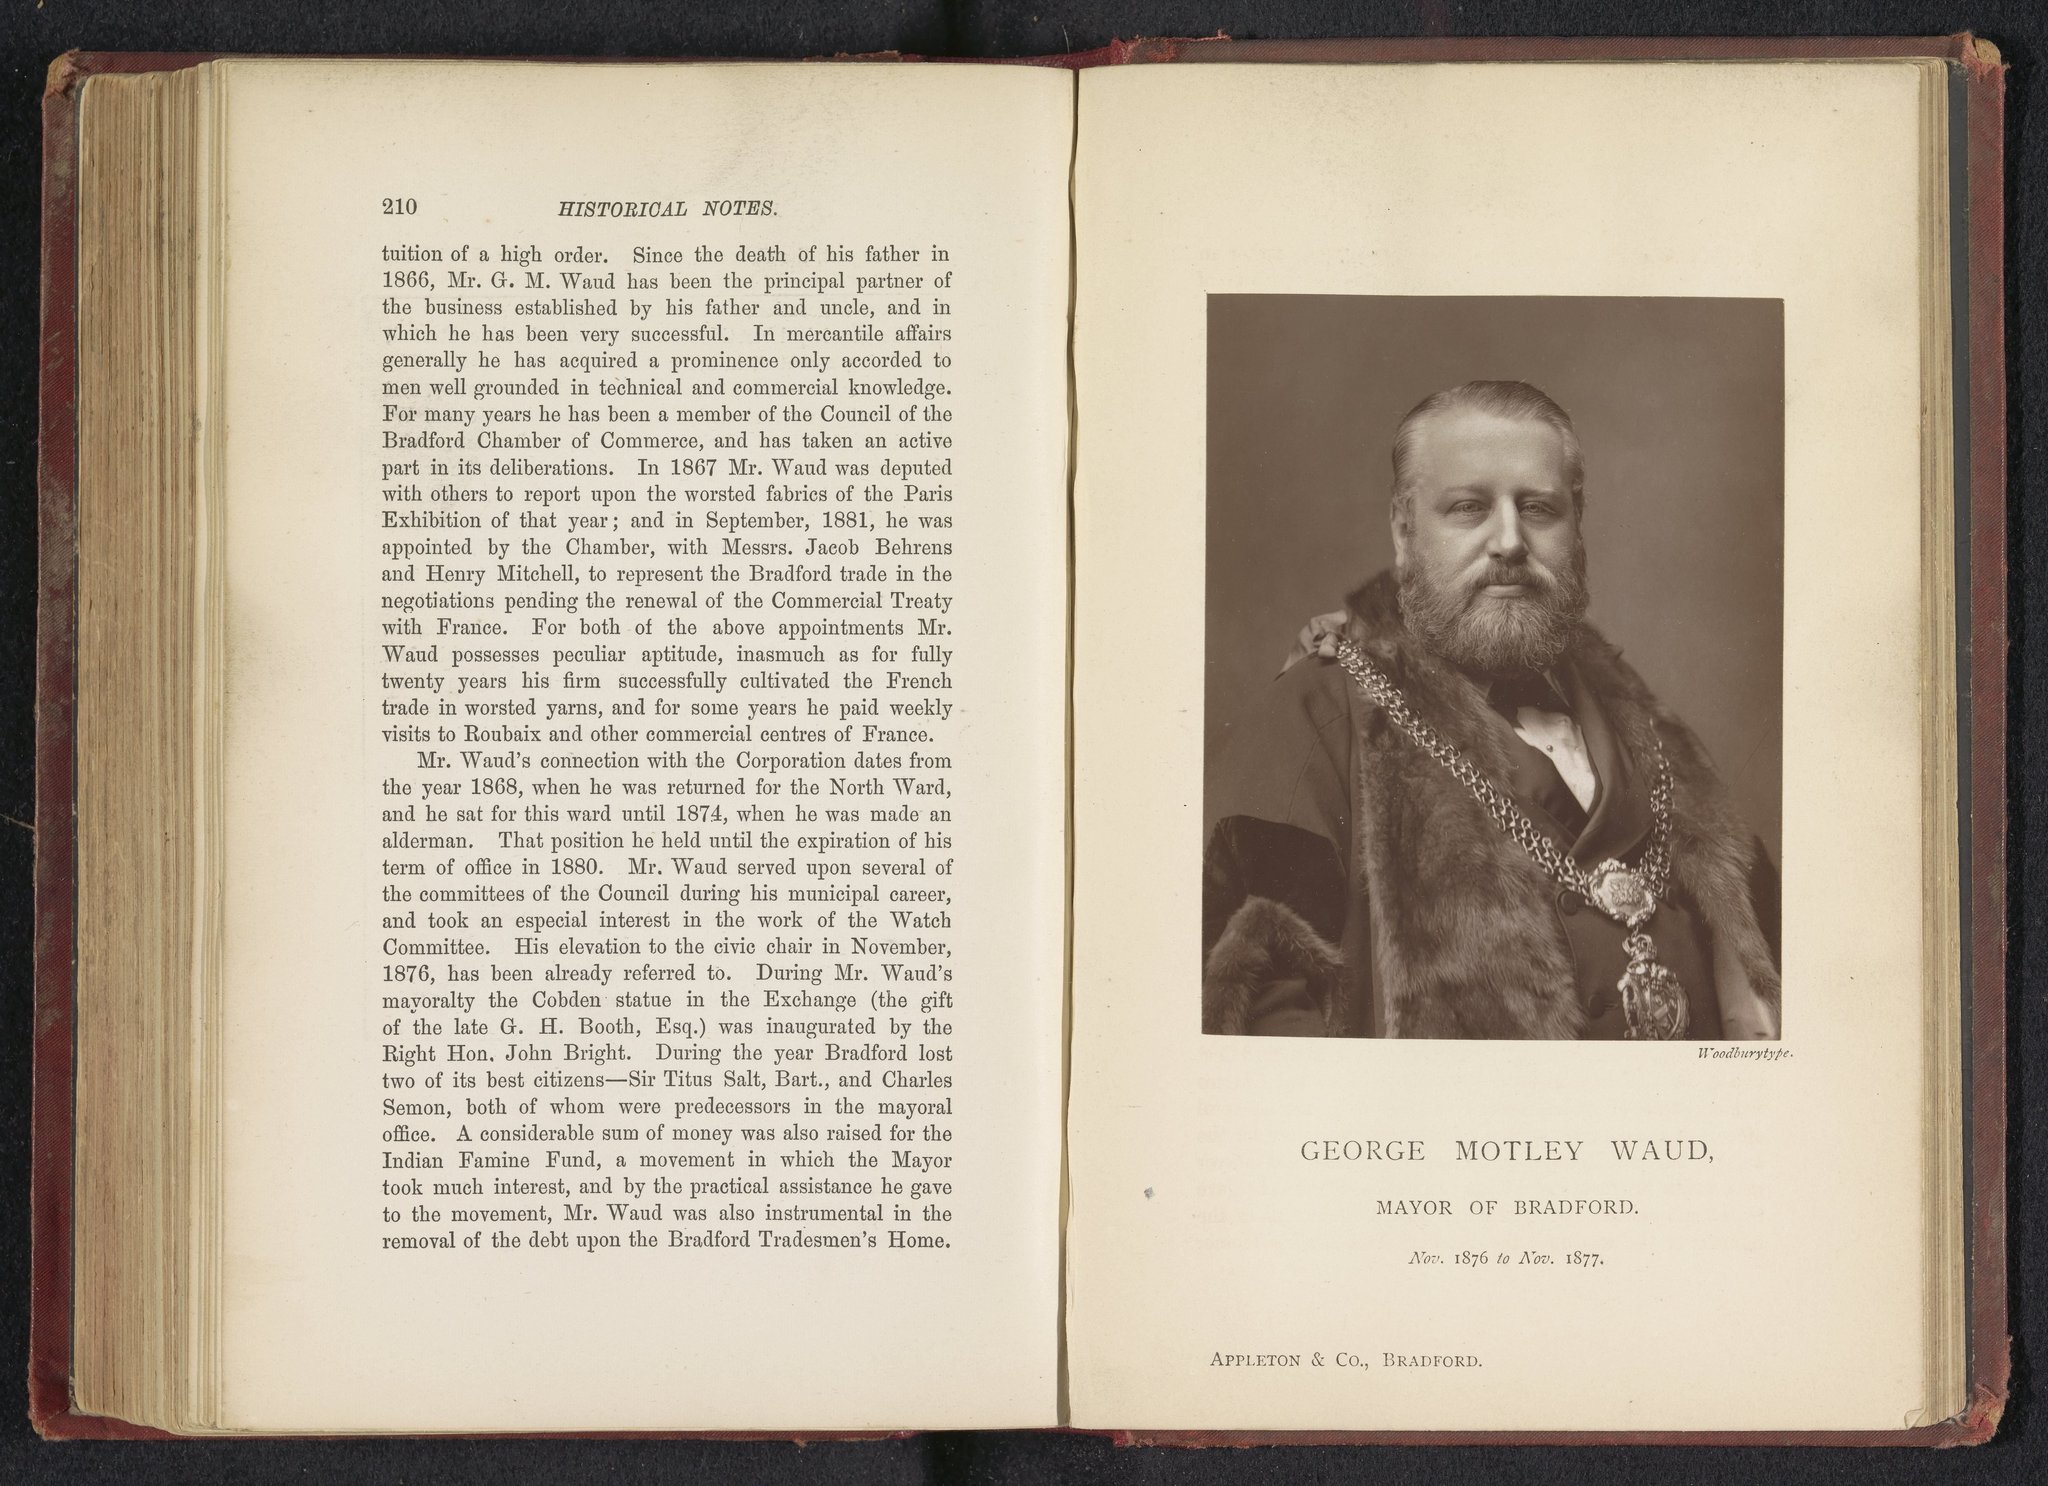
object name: page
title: George Motley Waud, mayor of Bradford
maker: Anonymous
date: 1871-1881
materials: paper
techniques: woodburytype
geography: bradford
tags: historical persons (portraits and scenes from the life) (+ (full) bust portrait)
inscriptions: inscription: ‘Nov. 1876 to Nov. 1877.’